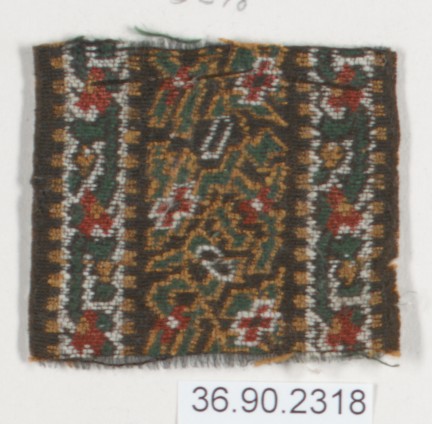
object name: border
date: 1801-1900